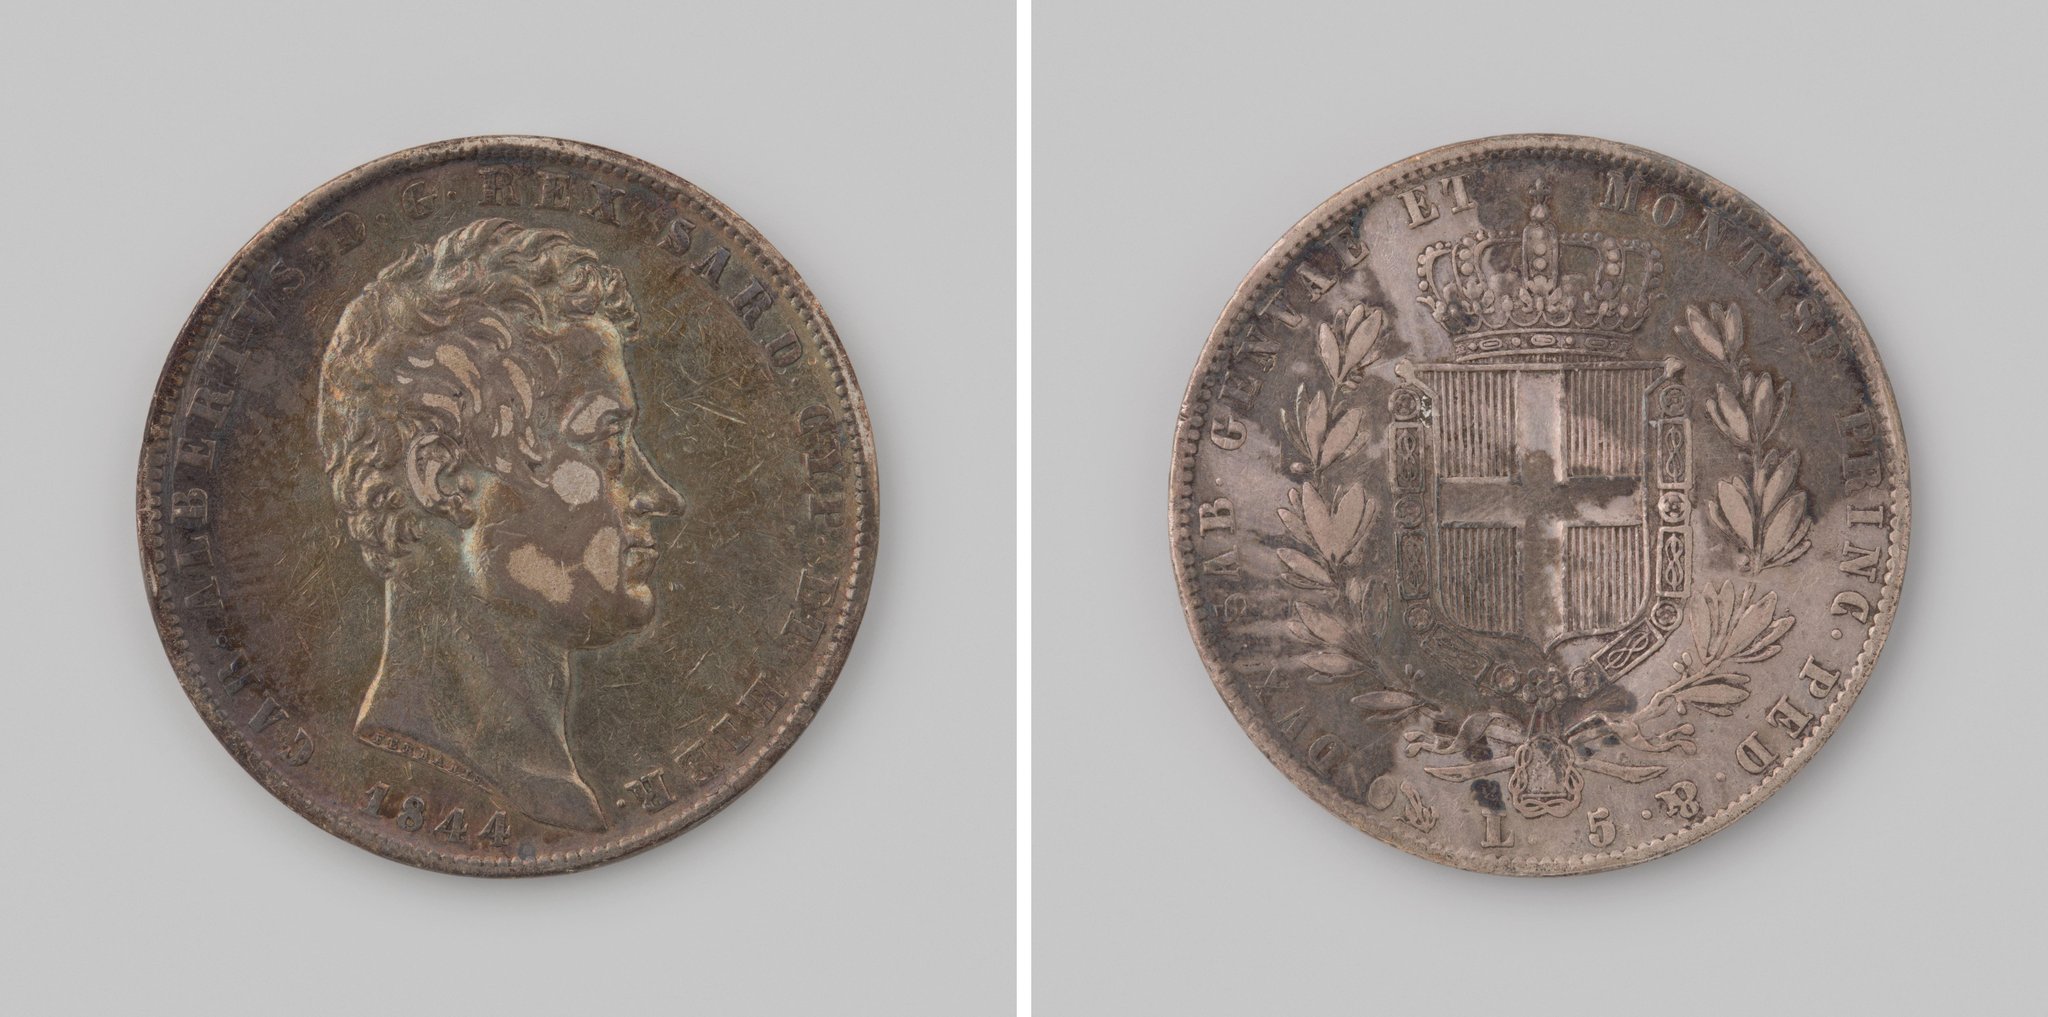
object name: coin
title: 5 lire uit Sardinië van koning Carlo Alberto, 1844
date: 1844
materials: silver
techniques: striking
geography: genoa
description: Zilveren munt. Voorzijde: hoofd van de koning naar rechts. Daaronder jaartal. Keerzijde: binnen twee takken door keten van ridderorde met juweel omhangen gekroond wapenschild. Waarde-aanduiding onderaan in omschrift. Links daarvan muntteken: anker [=Genua]. Randschrift.